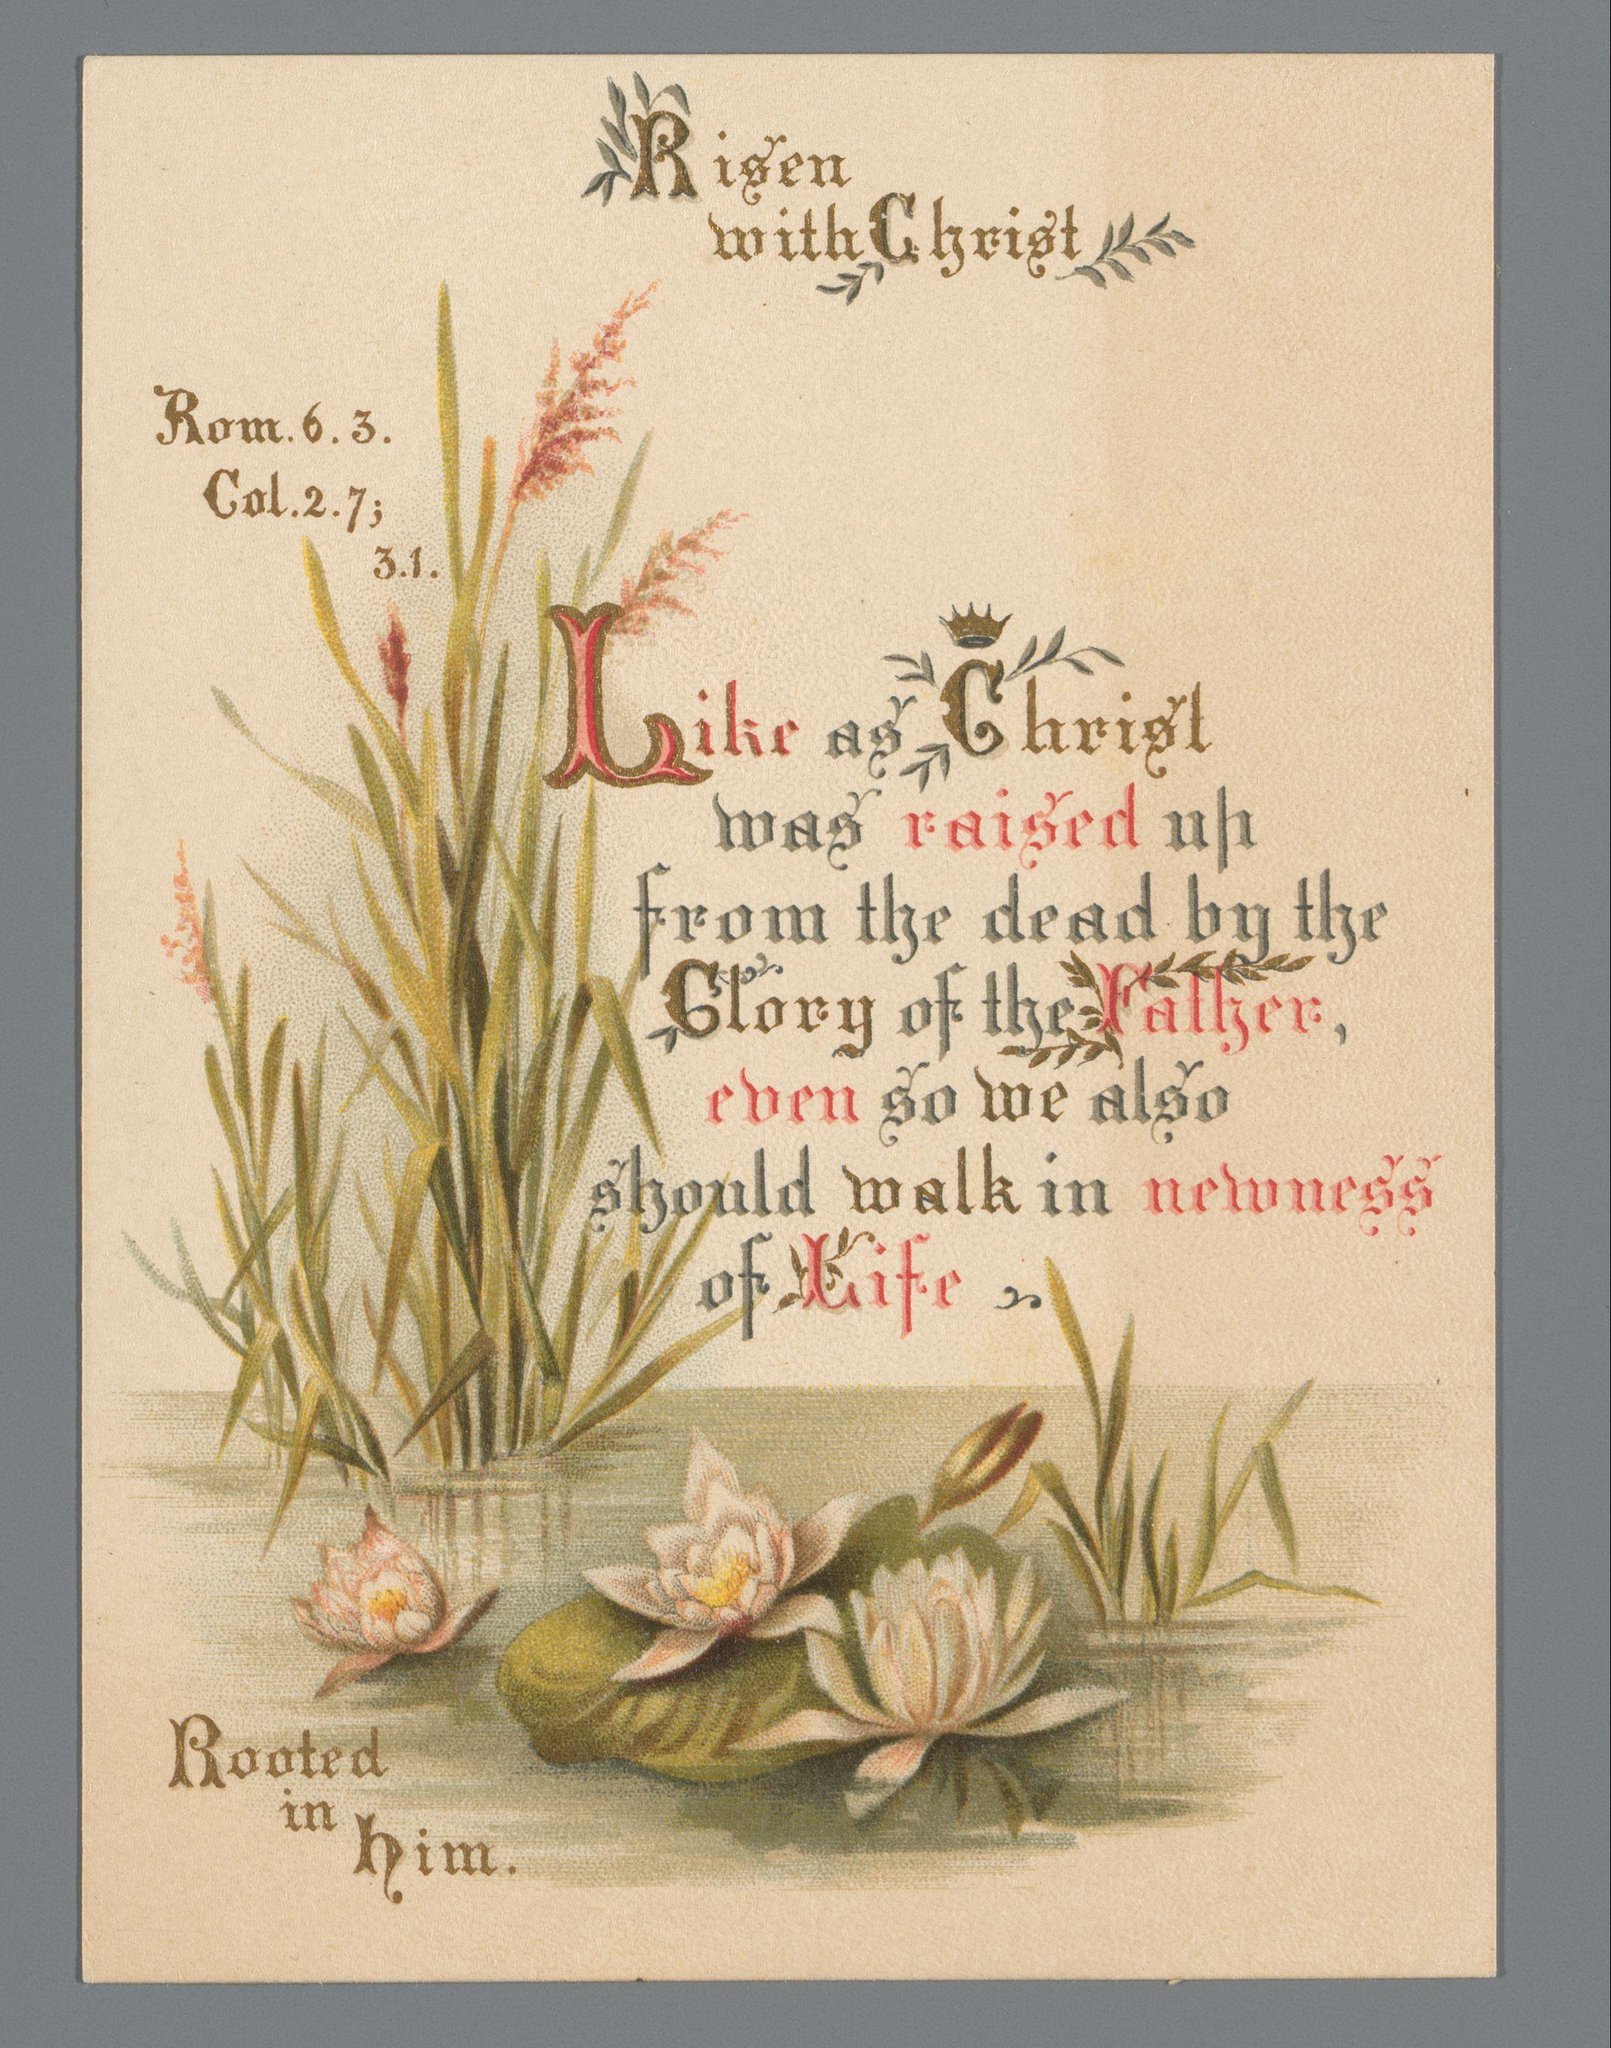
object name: greeting card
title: Paaskaart voor 1883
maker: Anonymous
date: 1883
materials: paper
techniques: chromolithography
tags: easter, flowers: water-lily, plants and herbs: reed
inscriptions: annotation: ‘Pour chère Madame Six [?] (...) Brighton 1883’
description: Bloeiende waterlelies en riet. Daarbij de teksten: 'Rom. 6.3. Col. 2.7; 3.1. Risen with Christ. Like as Christ was raised up from the dead by the Glory of the Father, even so we also should walk in newness of Life. Rooted in Him'.